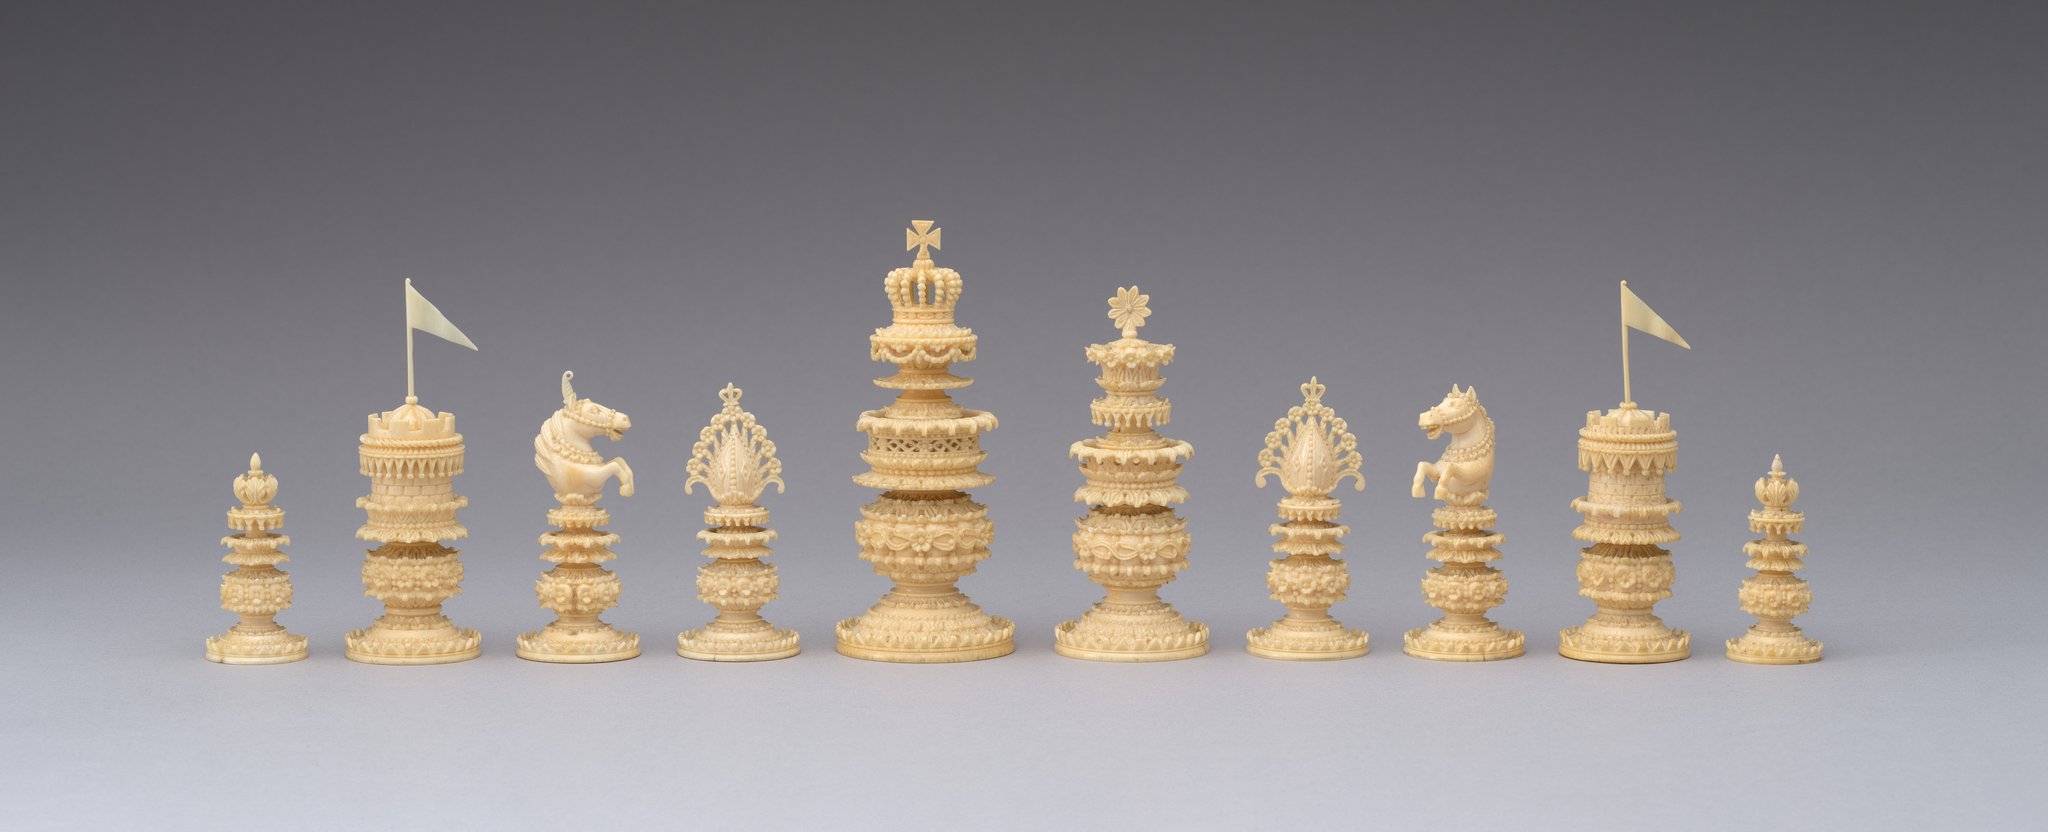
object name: chessman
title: Chessmen (32)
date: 1801-1900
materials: ivory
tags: chess,games